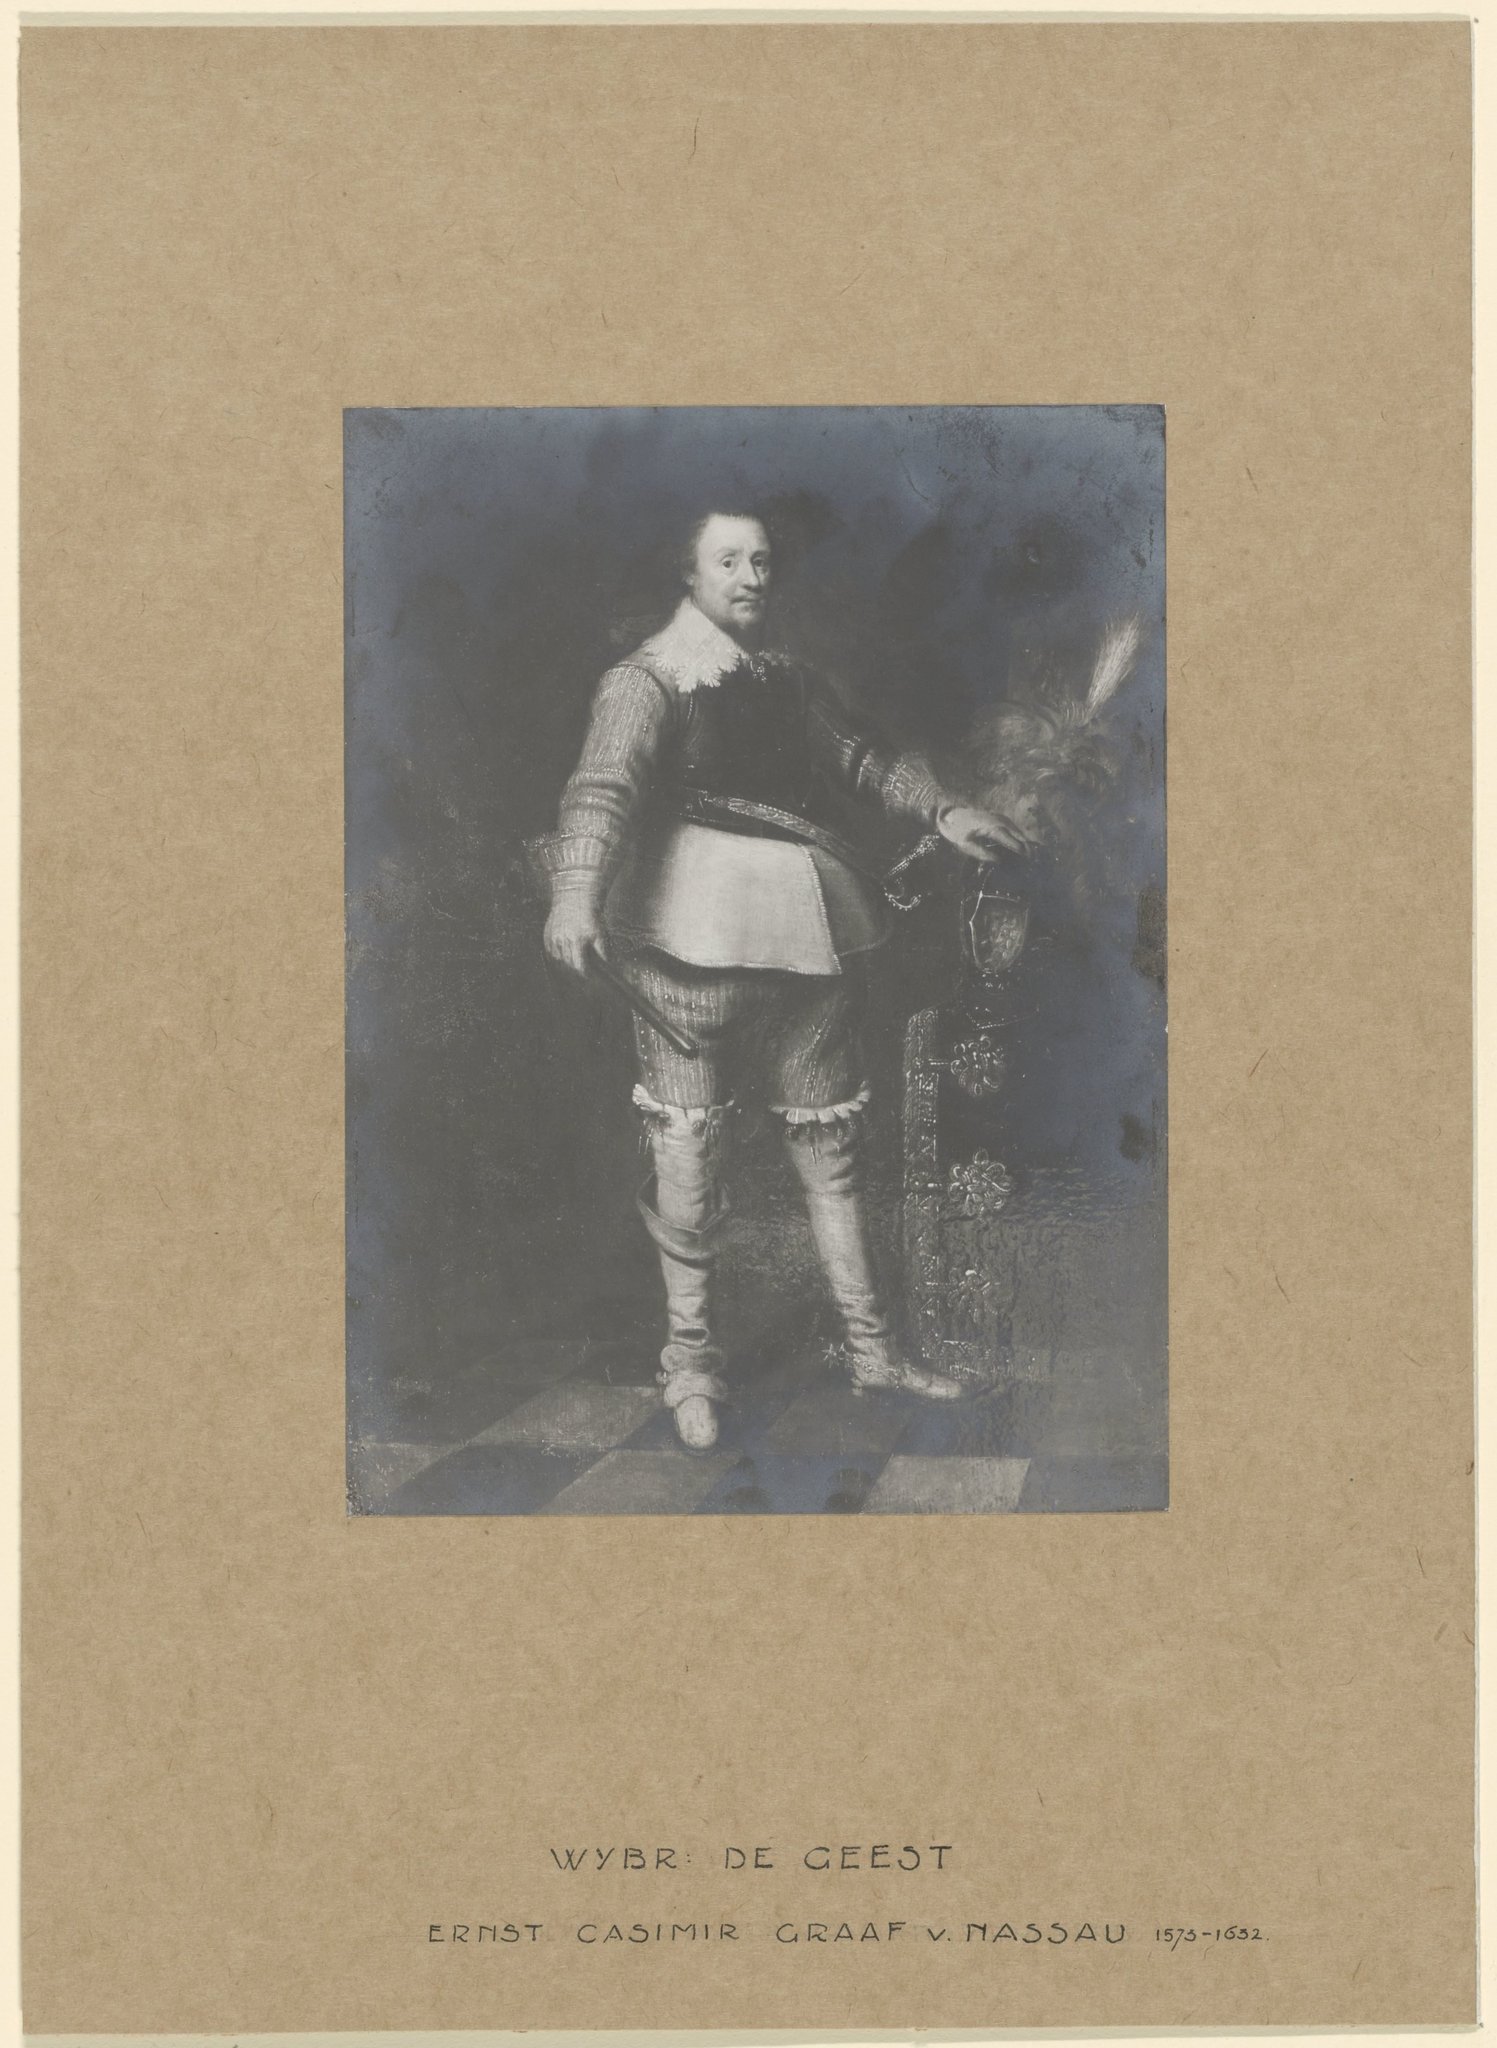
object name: photograph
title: Portret van Ernst Casimir, graaf van Nassau-Dietz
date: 1850-1930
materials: photographic support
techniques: photography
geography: netherlands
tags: ernst casimir graaf van nassau-dietz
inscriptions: collector's mark: Lugt 2233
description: De hier vermelde titel verwijst naar de hoogst verkregen titel van de geportretteerde, niet per se naar de titel die de geportretteerde op deze voorstelling draagt.